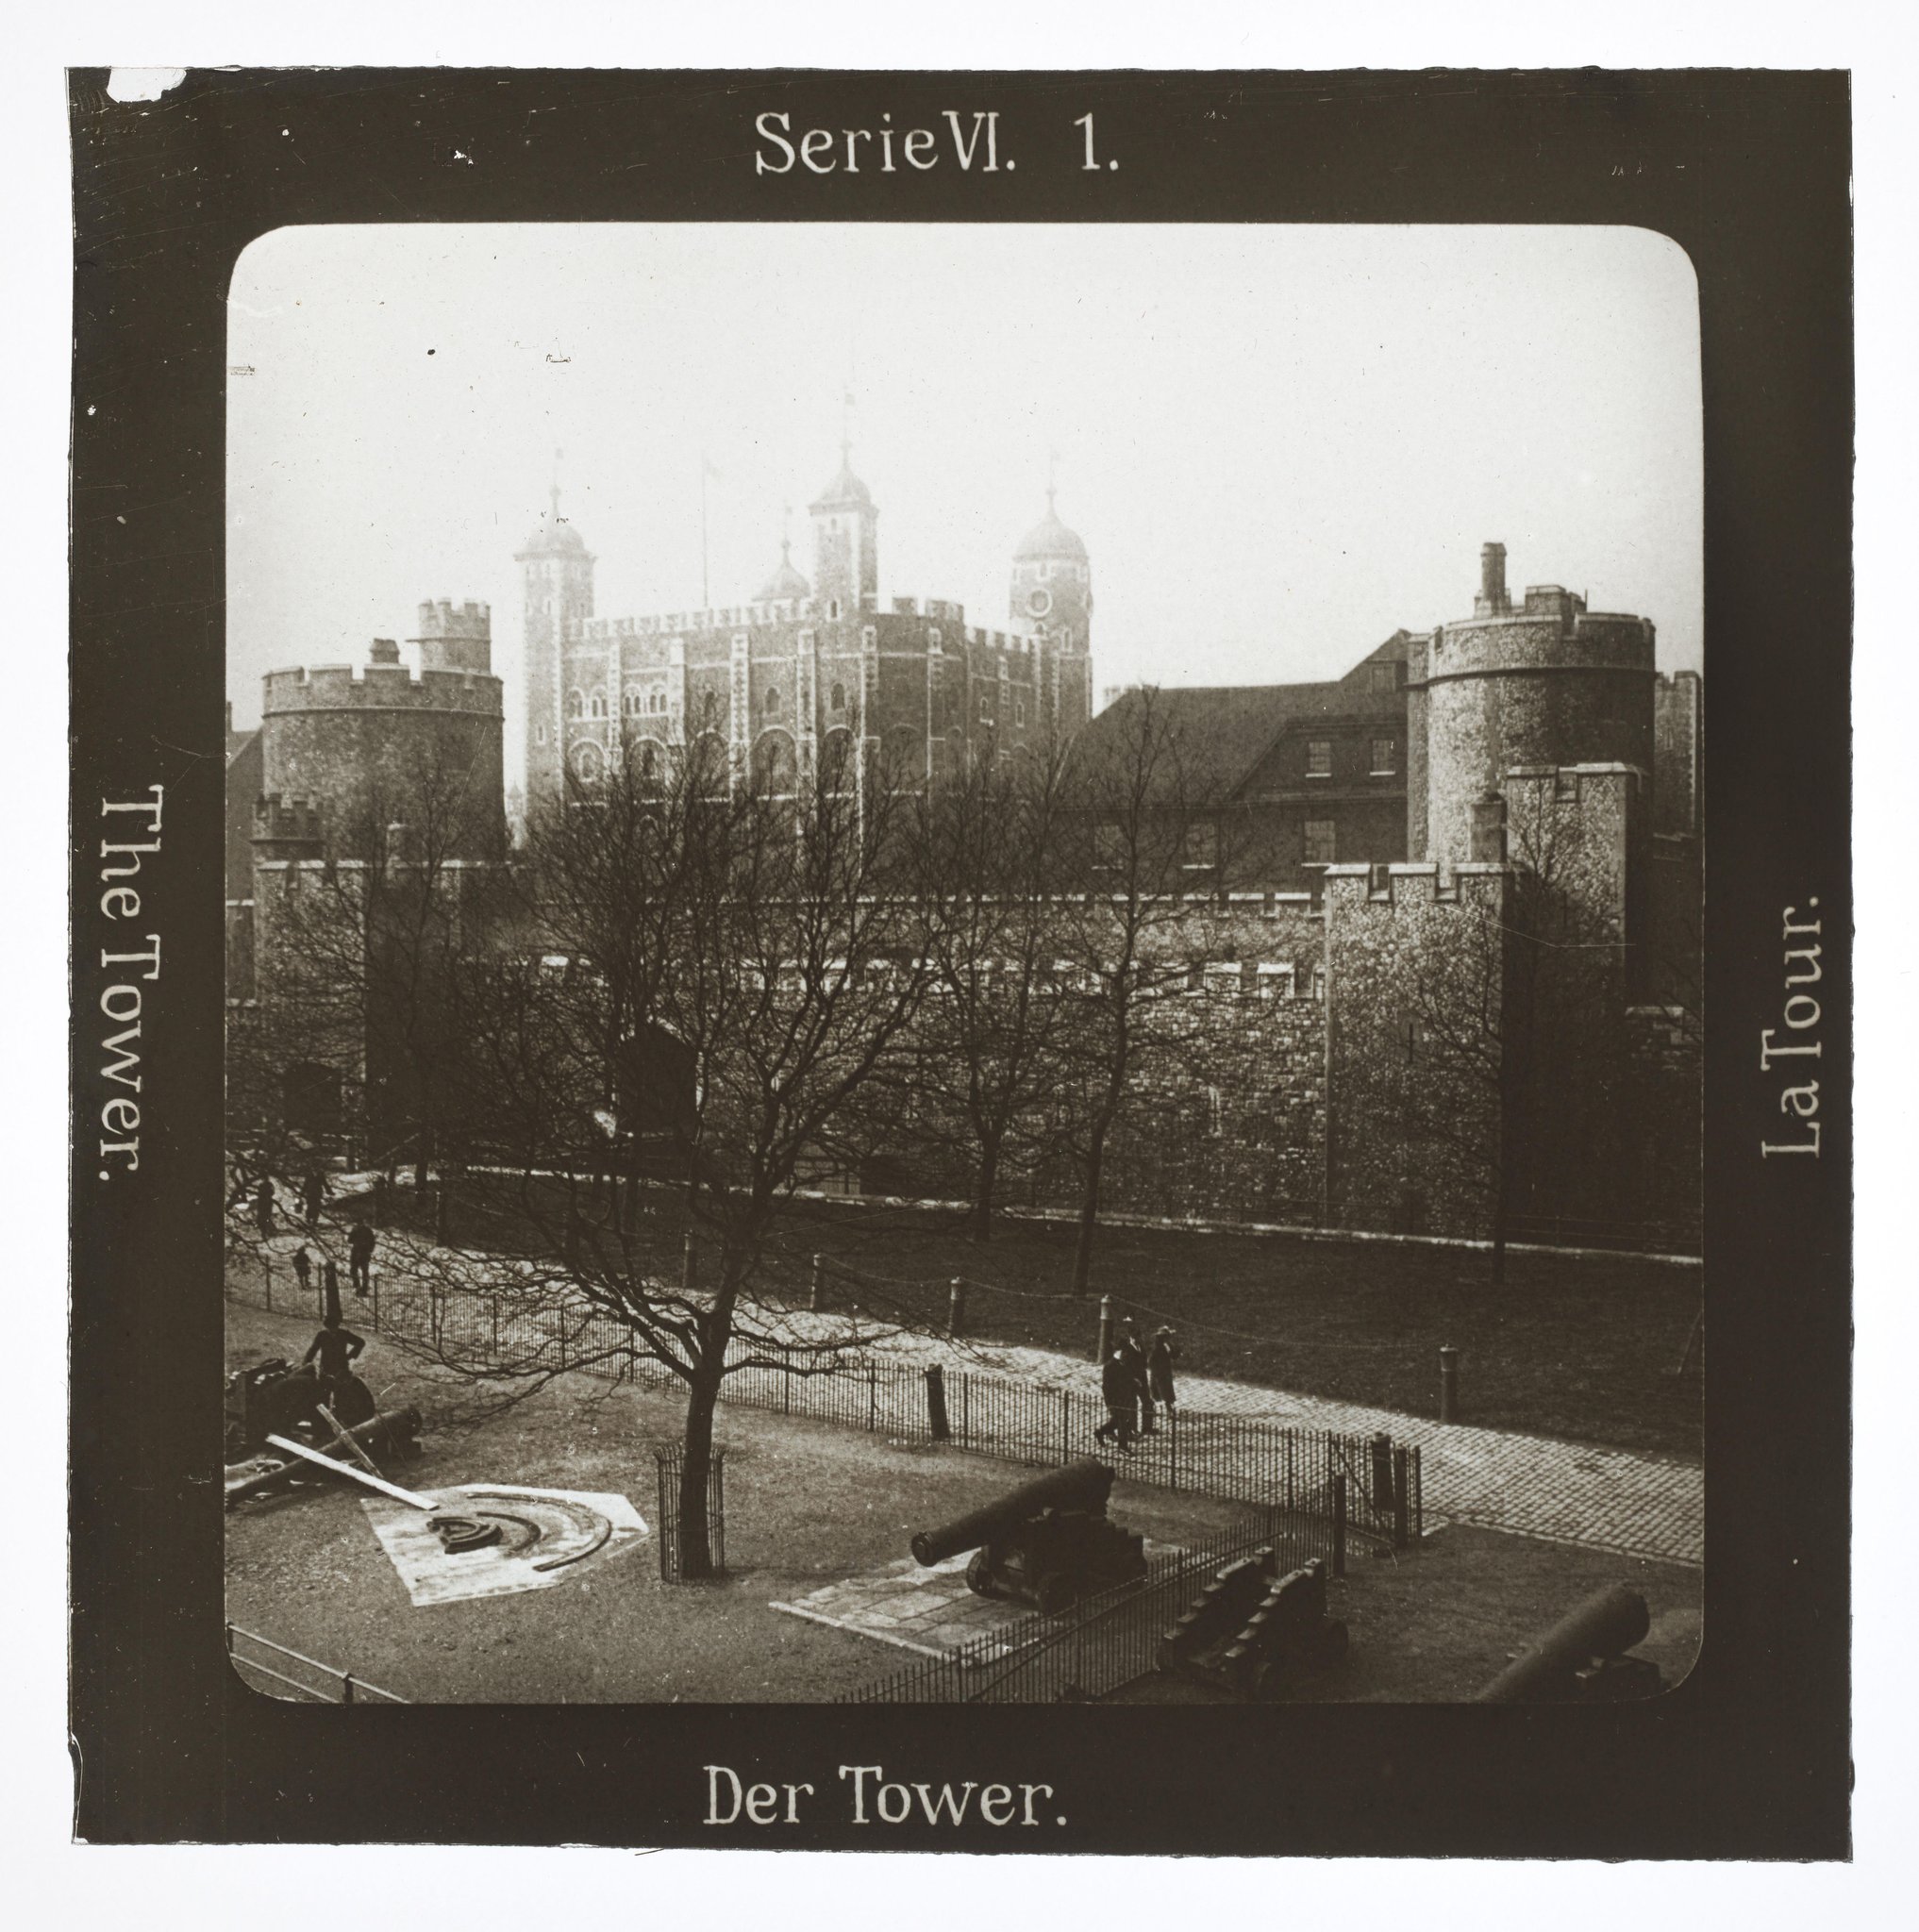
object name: lantern slide photographic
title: Der Tower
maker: Anonymous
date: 1900-1906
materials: glass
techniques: gelatin silver transparency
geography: london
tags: façade (of house or building), tower (of house or building)